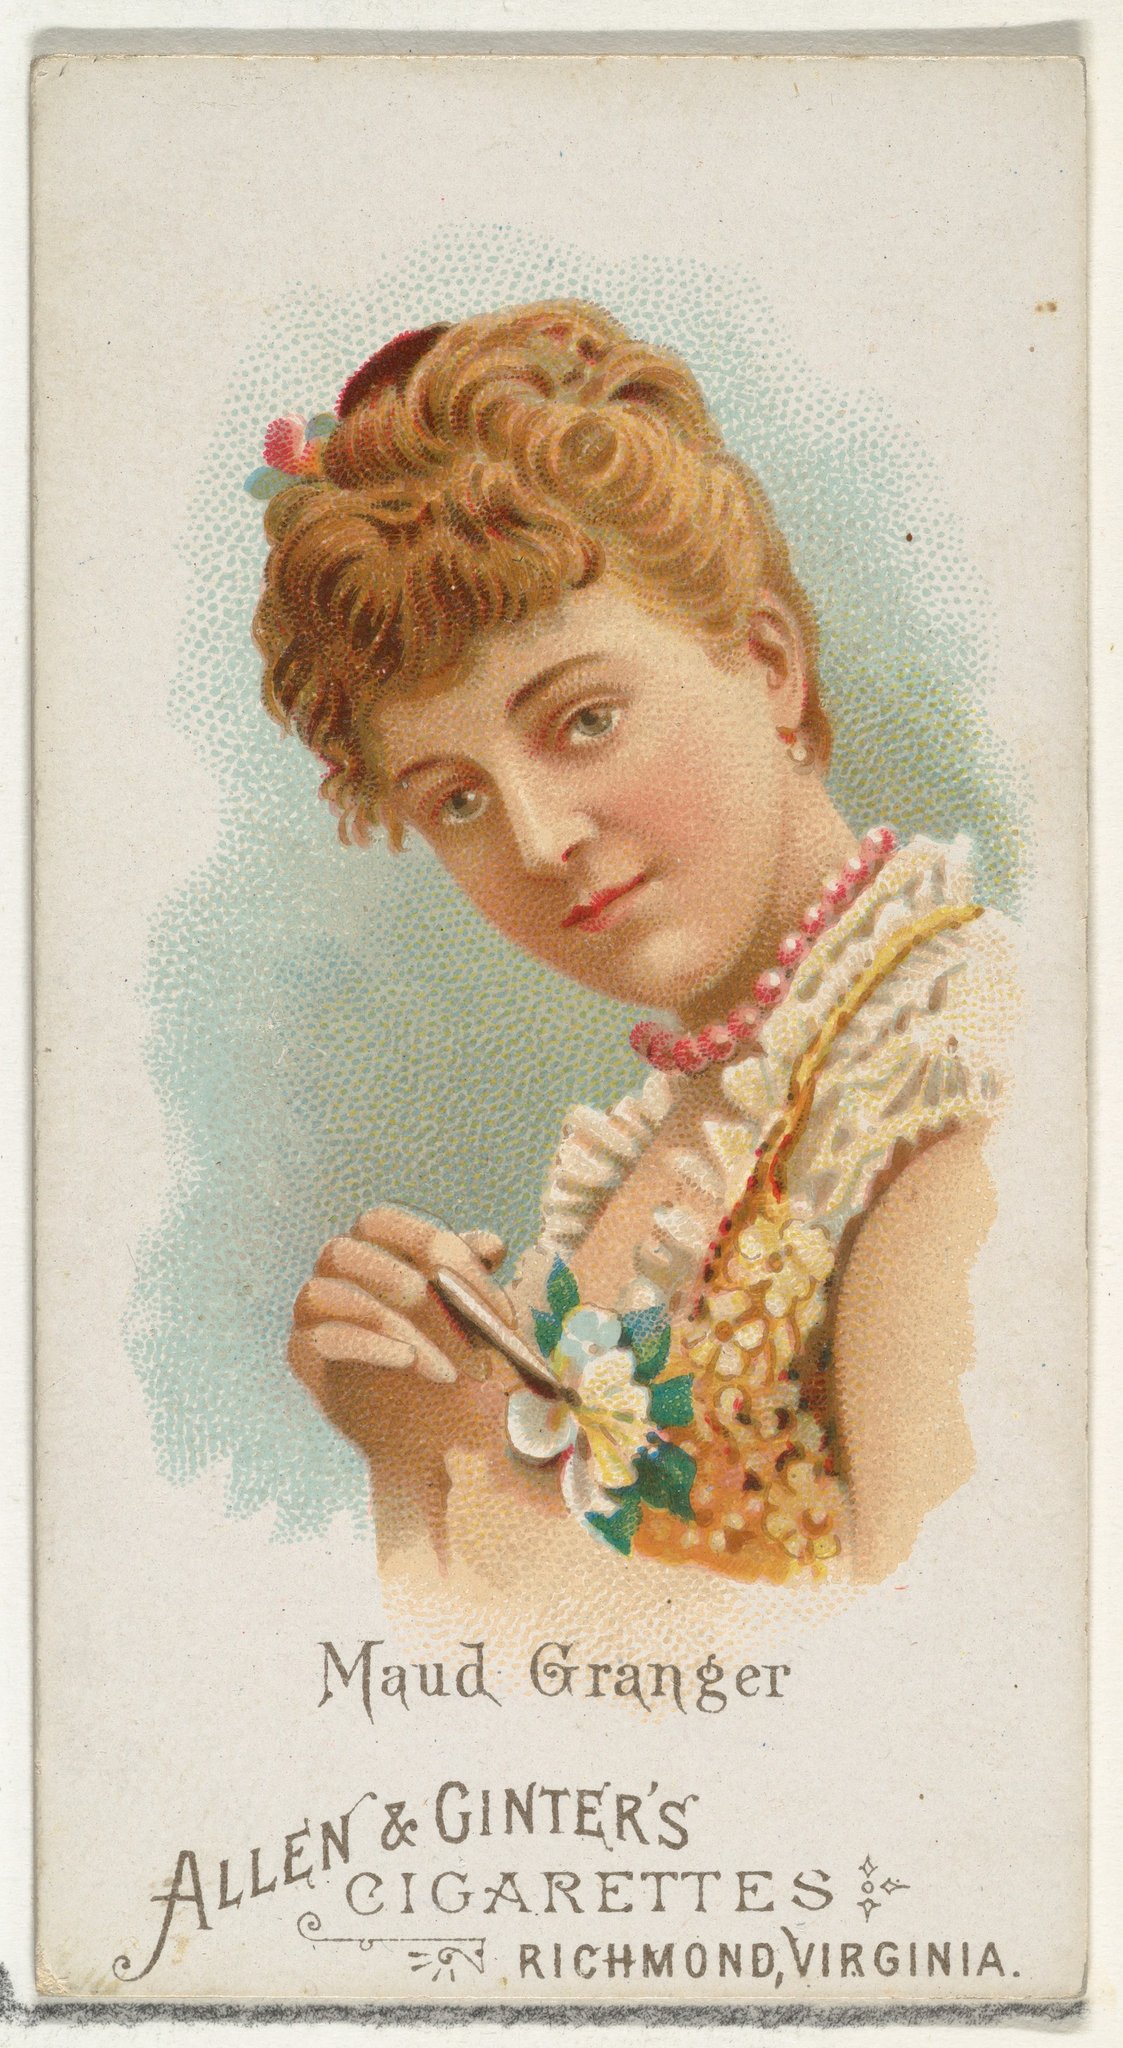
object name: print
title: Maud Granger, from World's Beauties, Series 1 (N26) for Allen & Ginter Cigarettes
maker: allen & ginter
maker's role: publisher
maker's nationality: american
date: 1888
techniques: color lithograph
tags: women